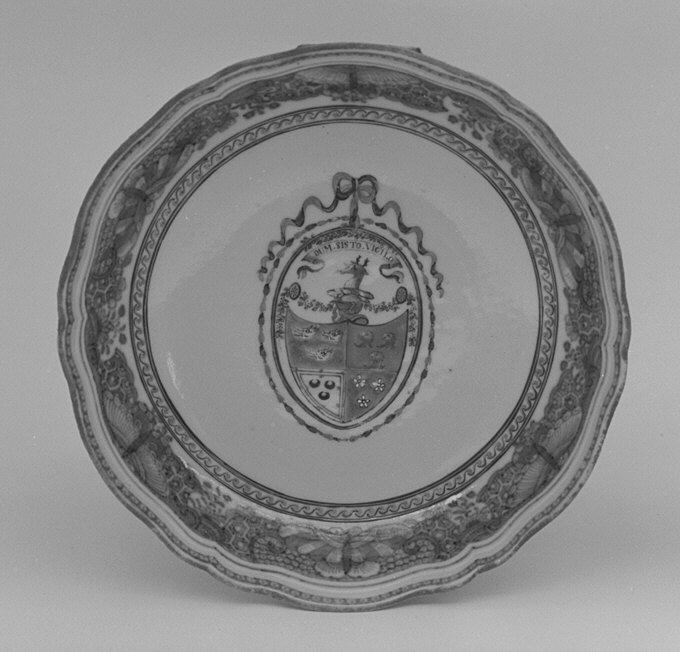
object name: saucer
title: Saucer (part of a service)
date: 1770-1785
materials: hard paste porcelain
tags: coat of arms